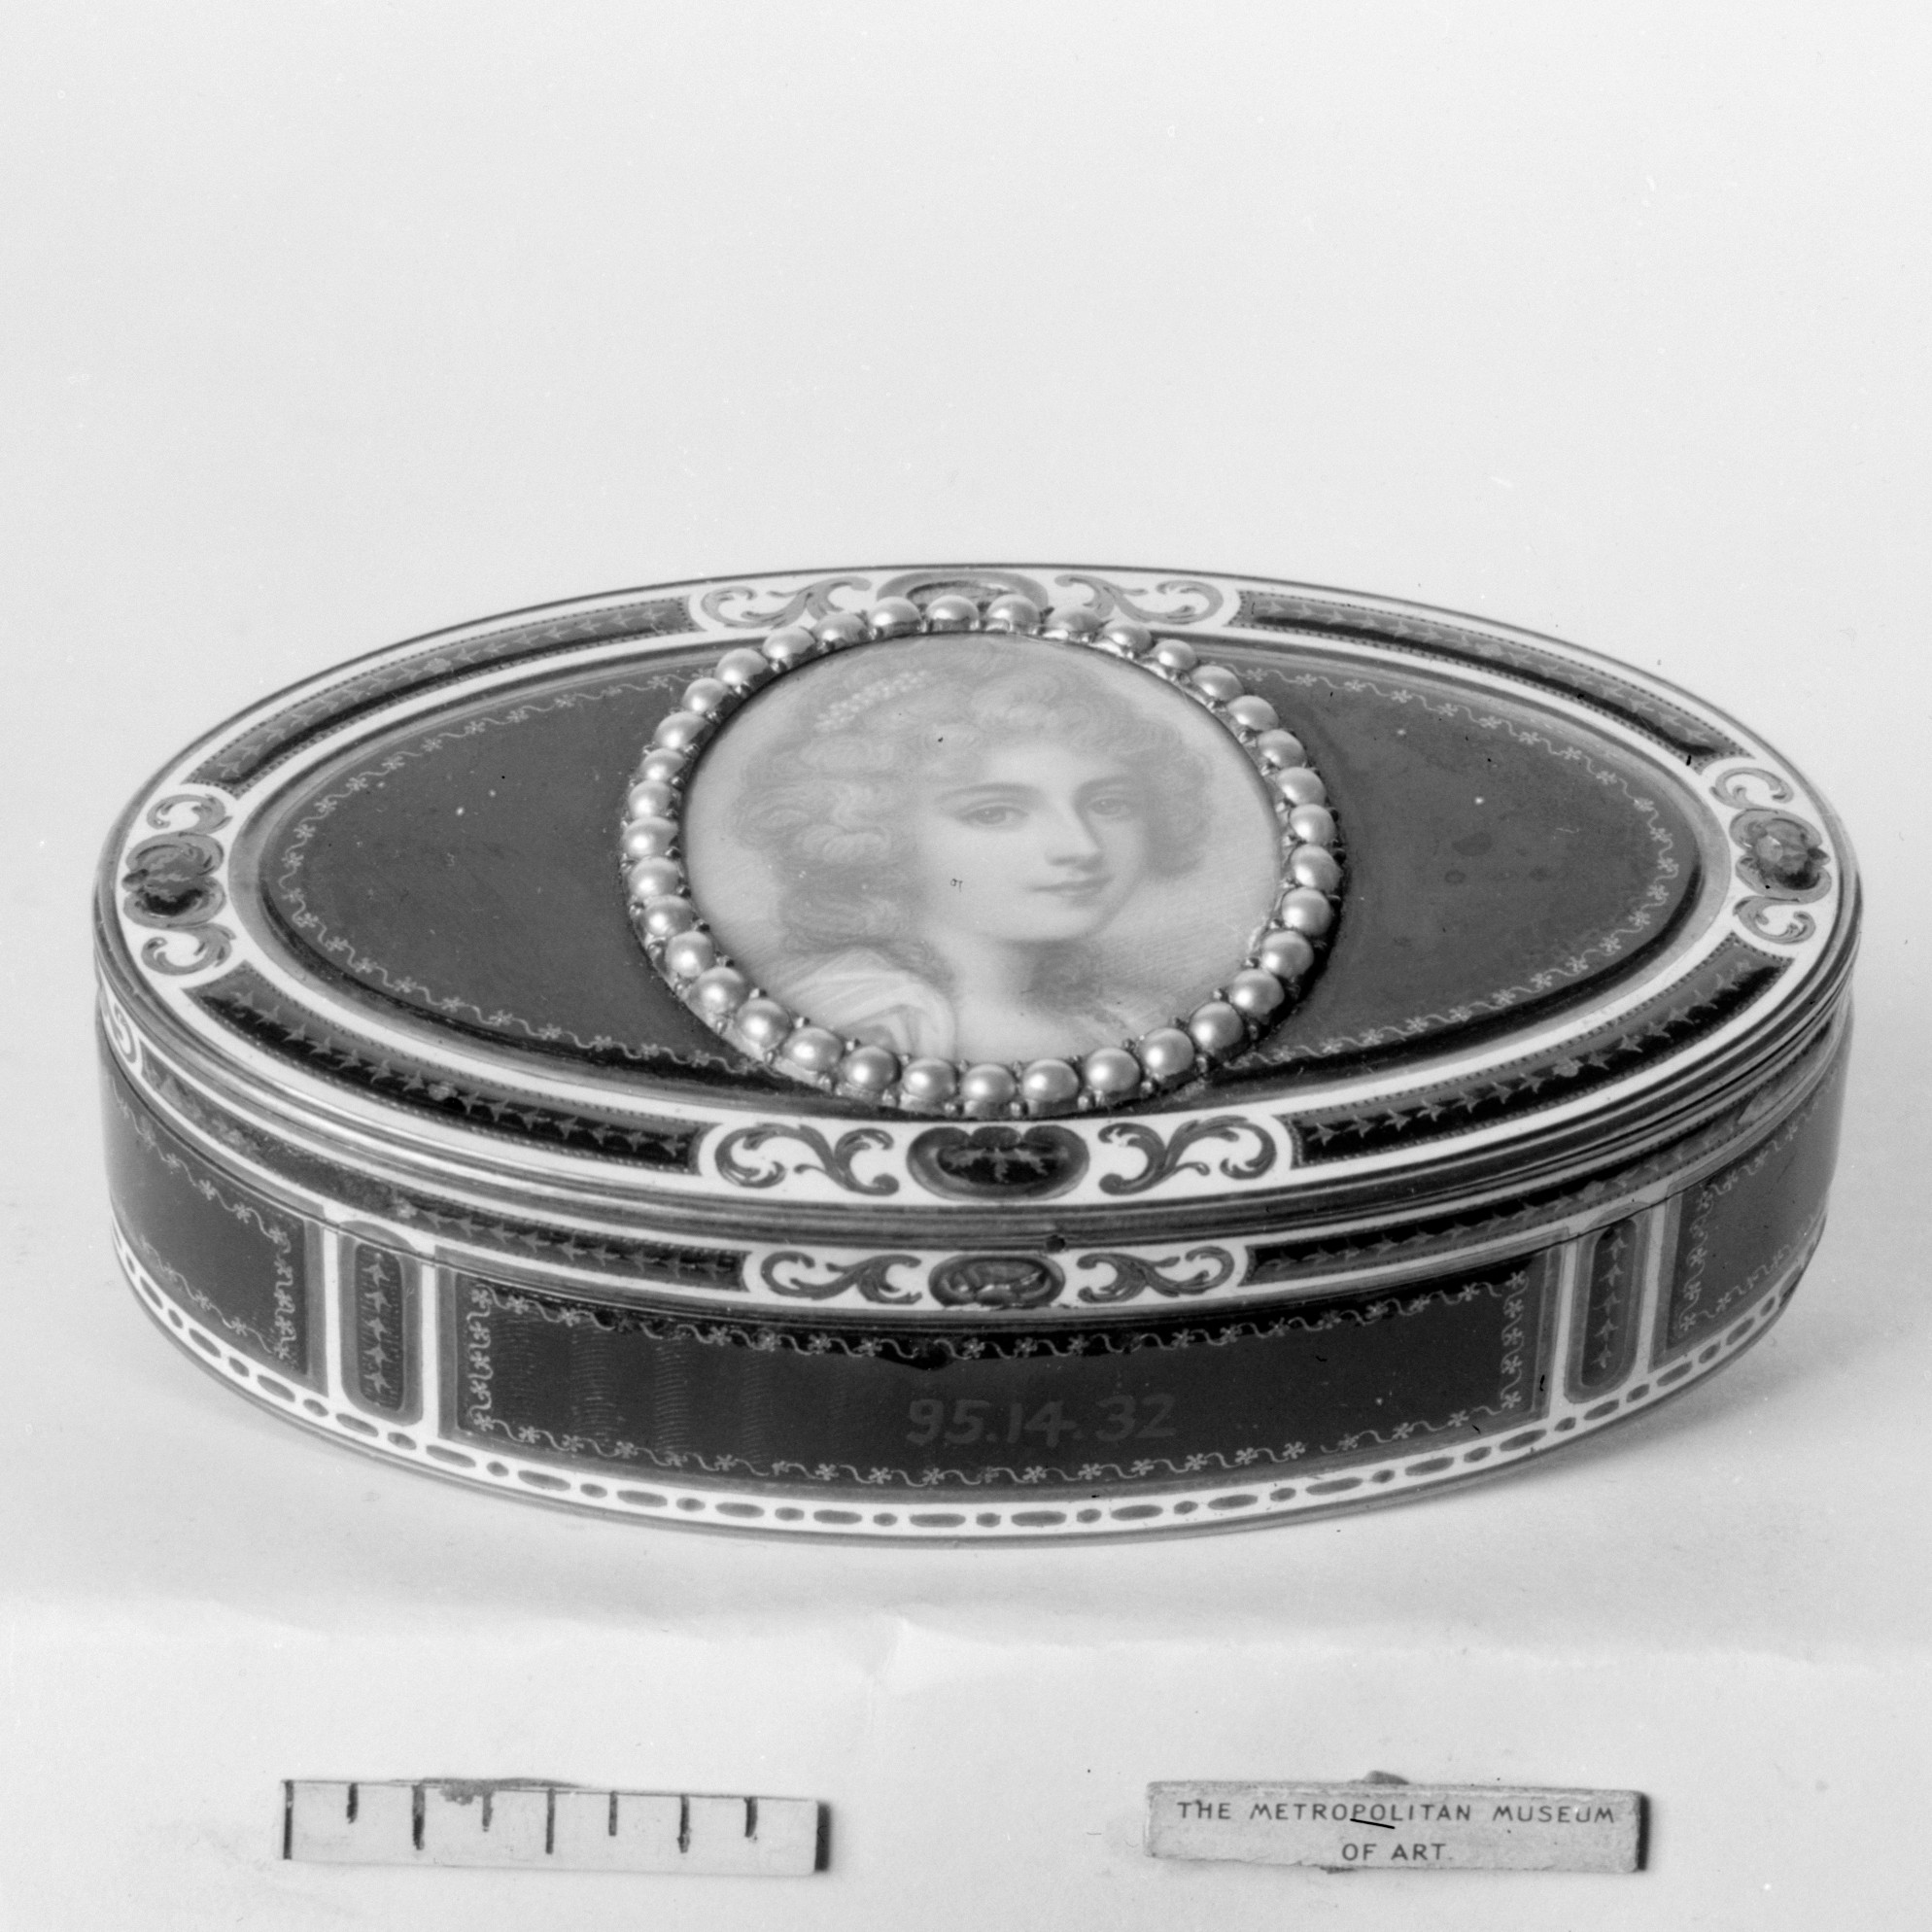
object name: snuffbox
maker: friedrich fyrwald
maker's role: maker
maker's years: 1713-1814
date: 1790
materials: enamel, gold, pearl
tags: portraits,women